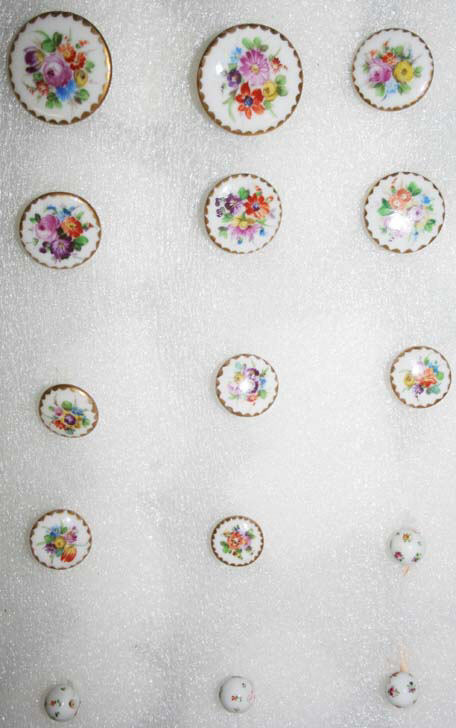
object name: button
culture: european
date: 1850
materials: porcelain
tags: flowers